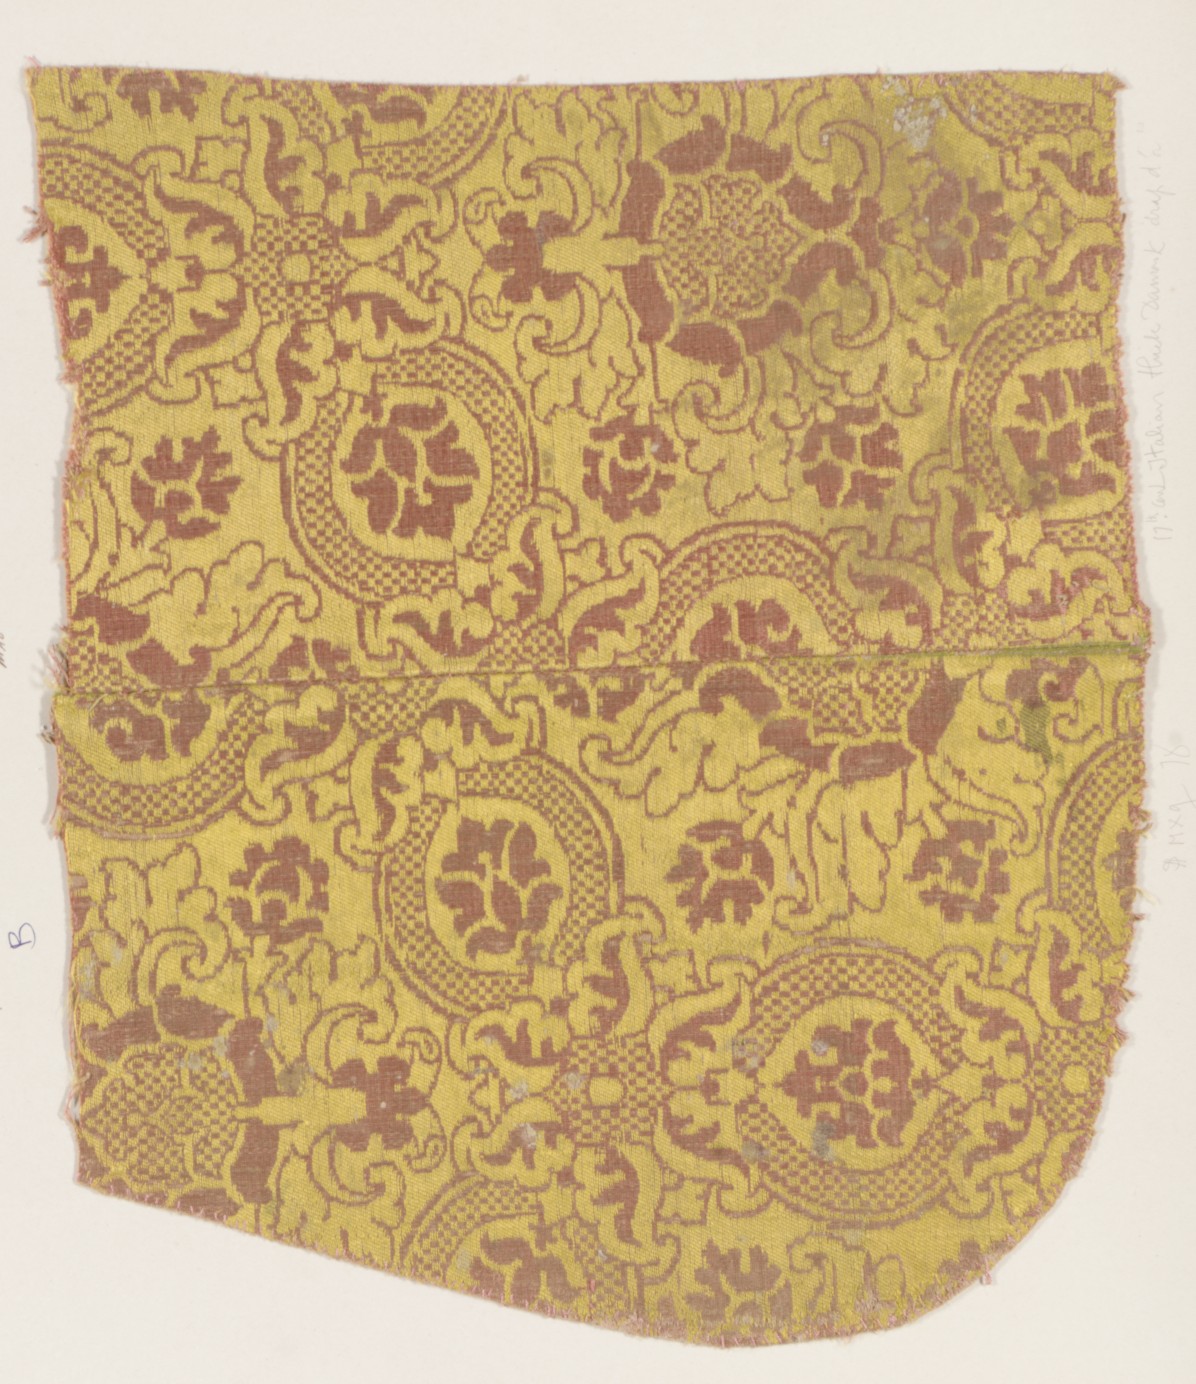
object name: fragment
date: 1601-1700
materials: silk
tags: leaves